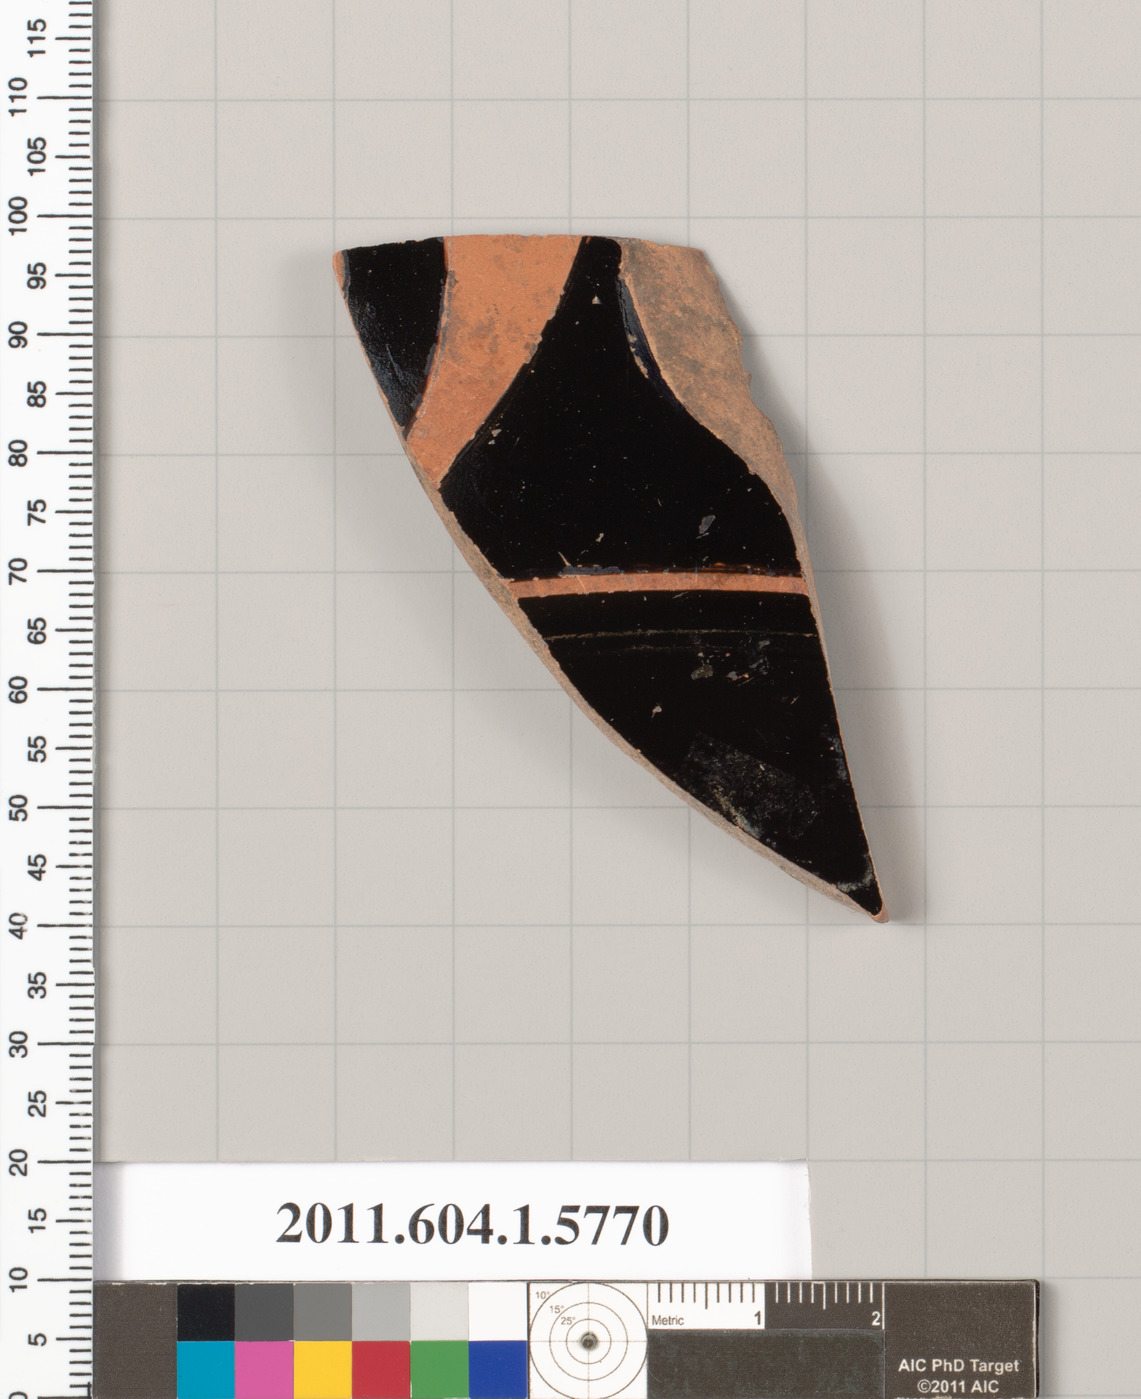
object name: kylix fragment, eye cup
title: Terracotta fragment of a kylix: eye-cup (drinking cup)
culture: greek, attic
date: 520-510 BCE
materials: terracotta